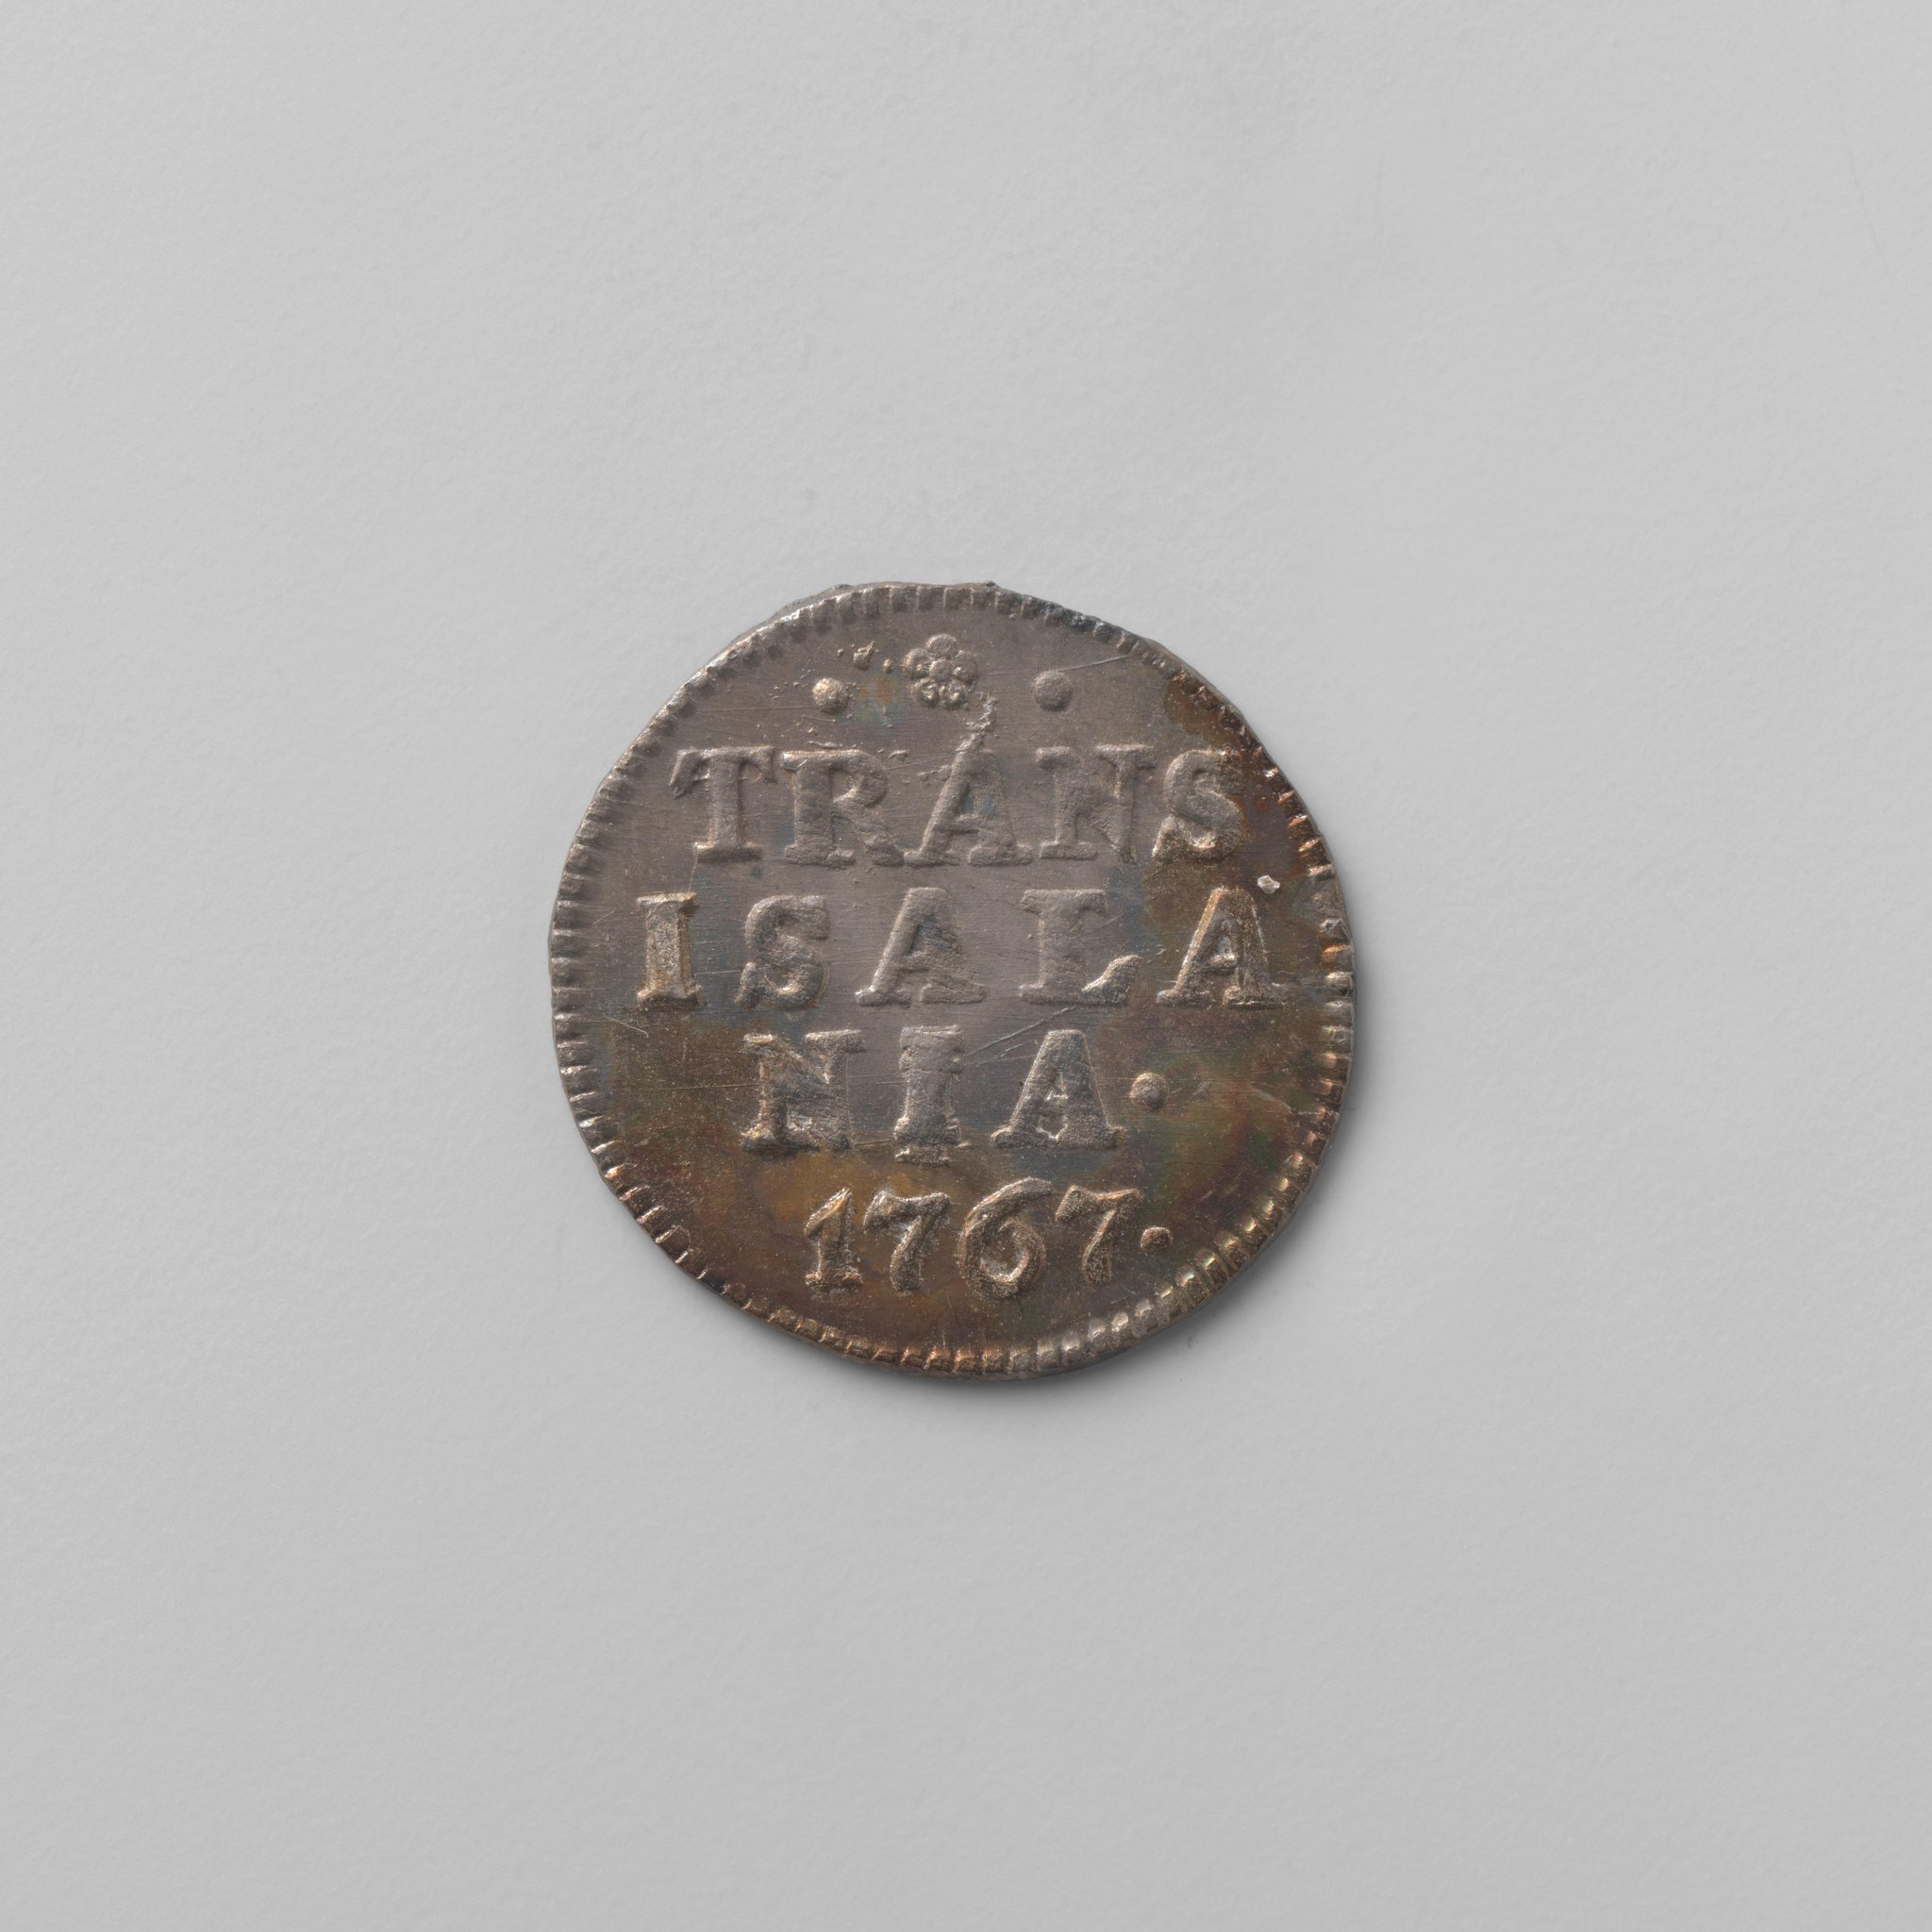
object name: coin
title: Overijsselse bezemstuiver, 1767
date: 1767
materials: silver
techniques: striking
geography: kampen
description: Zilveren munt. Voorzijde: drieregelig opschrift, waarboven muntmeesterteken en waaronder jaartal. Keerzijde: binnen lauwerkrans tussen waarde-aanduiding I S pijlenbundel. Gladde rand.